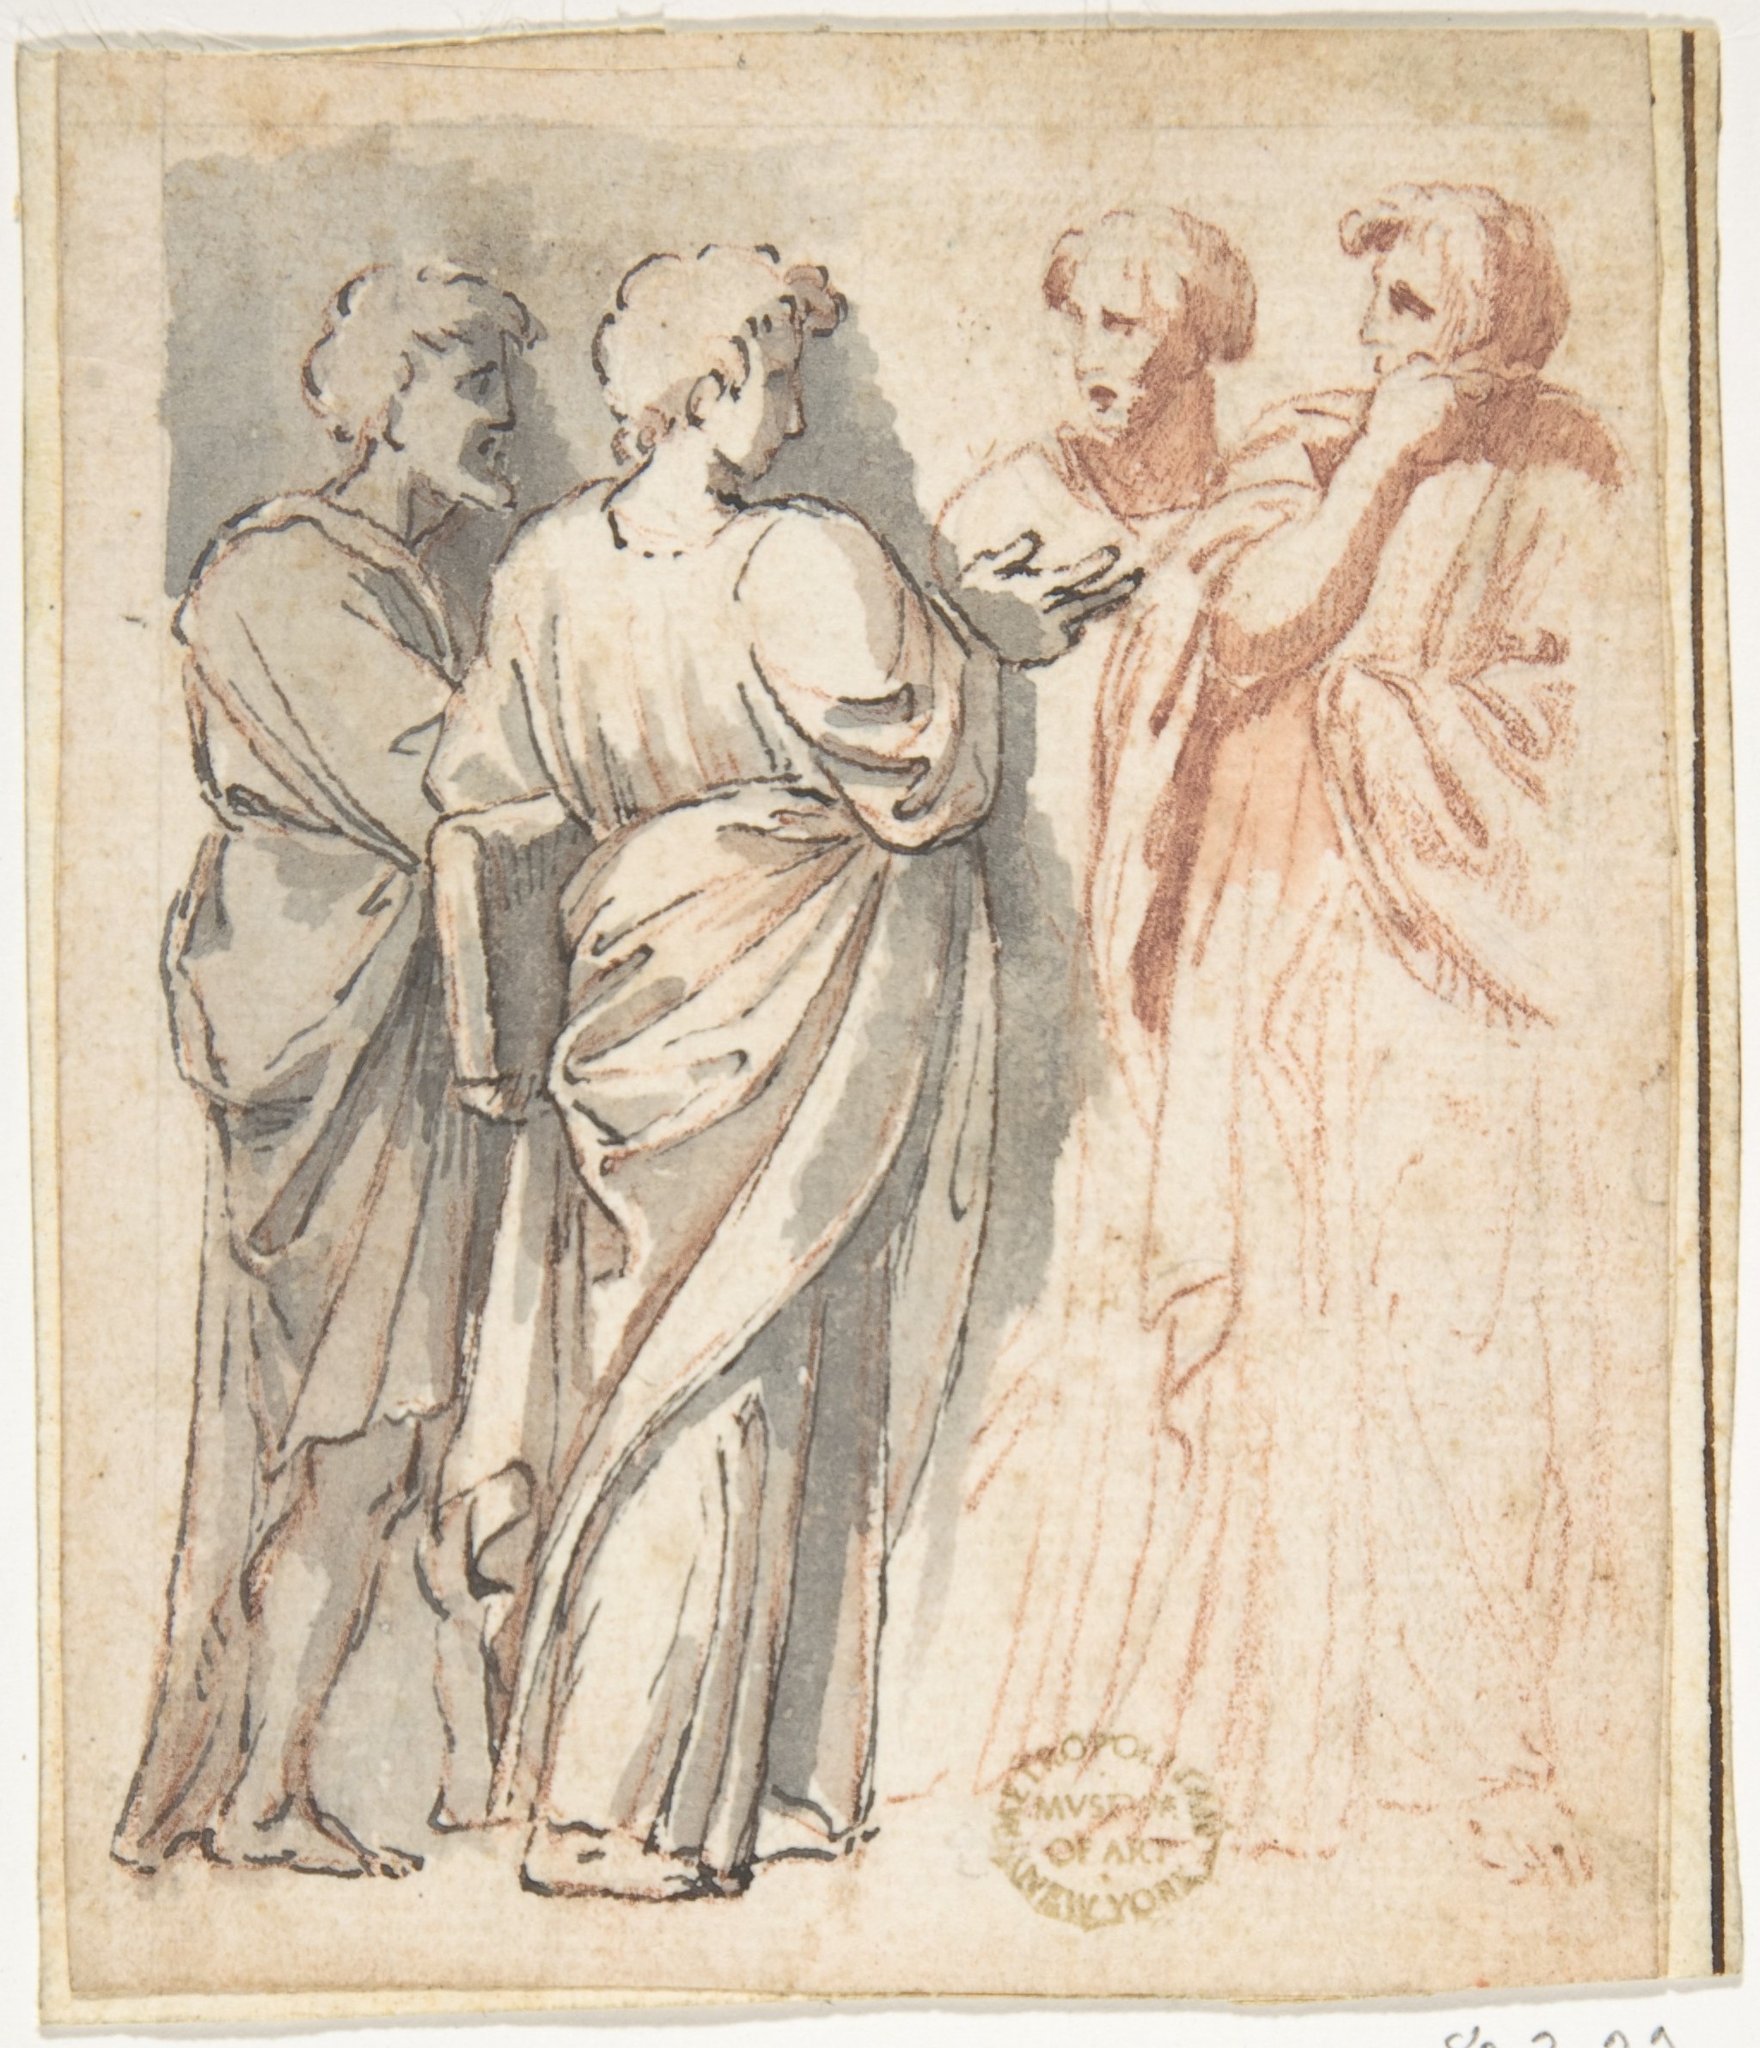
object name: drawing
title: Four Men Arguing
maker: anonymous, italian, 19th century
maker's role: artist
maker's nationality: italian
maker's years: 1800-1900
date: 1800-1900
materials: chalk, ink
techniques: pen, wash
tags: men